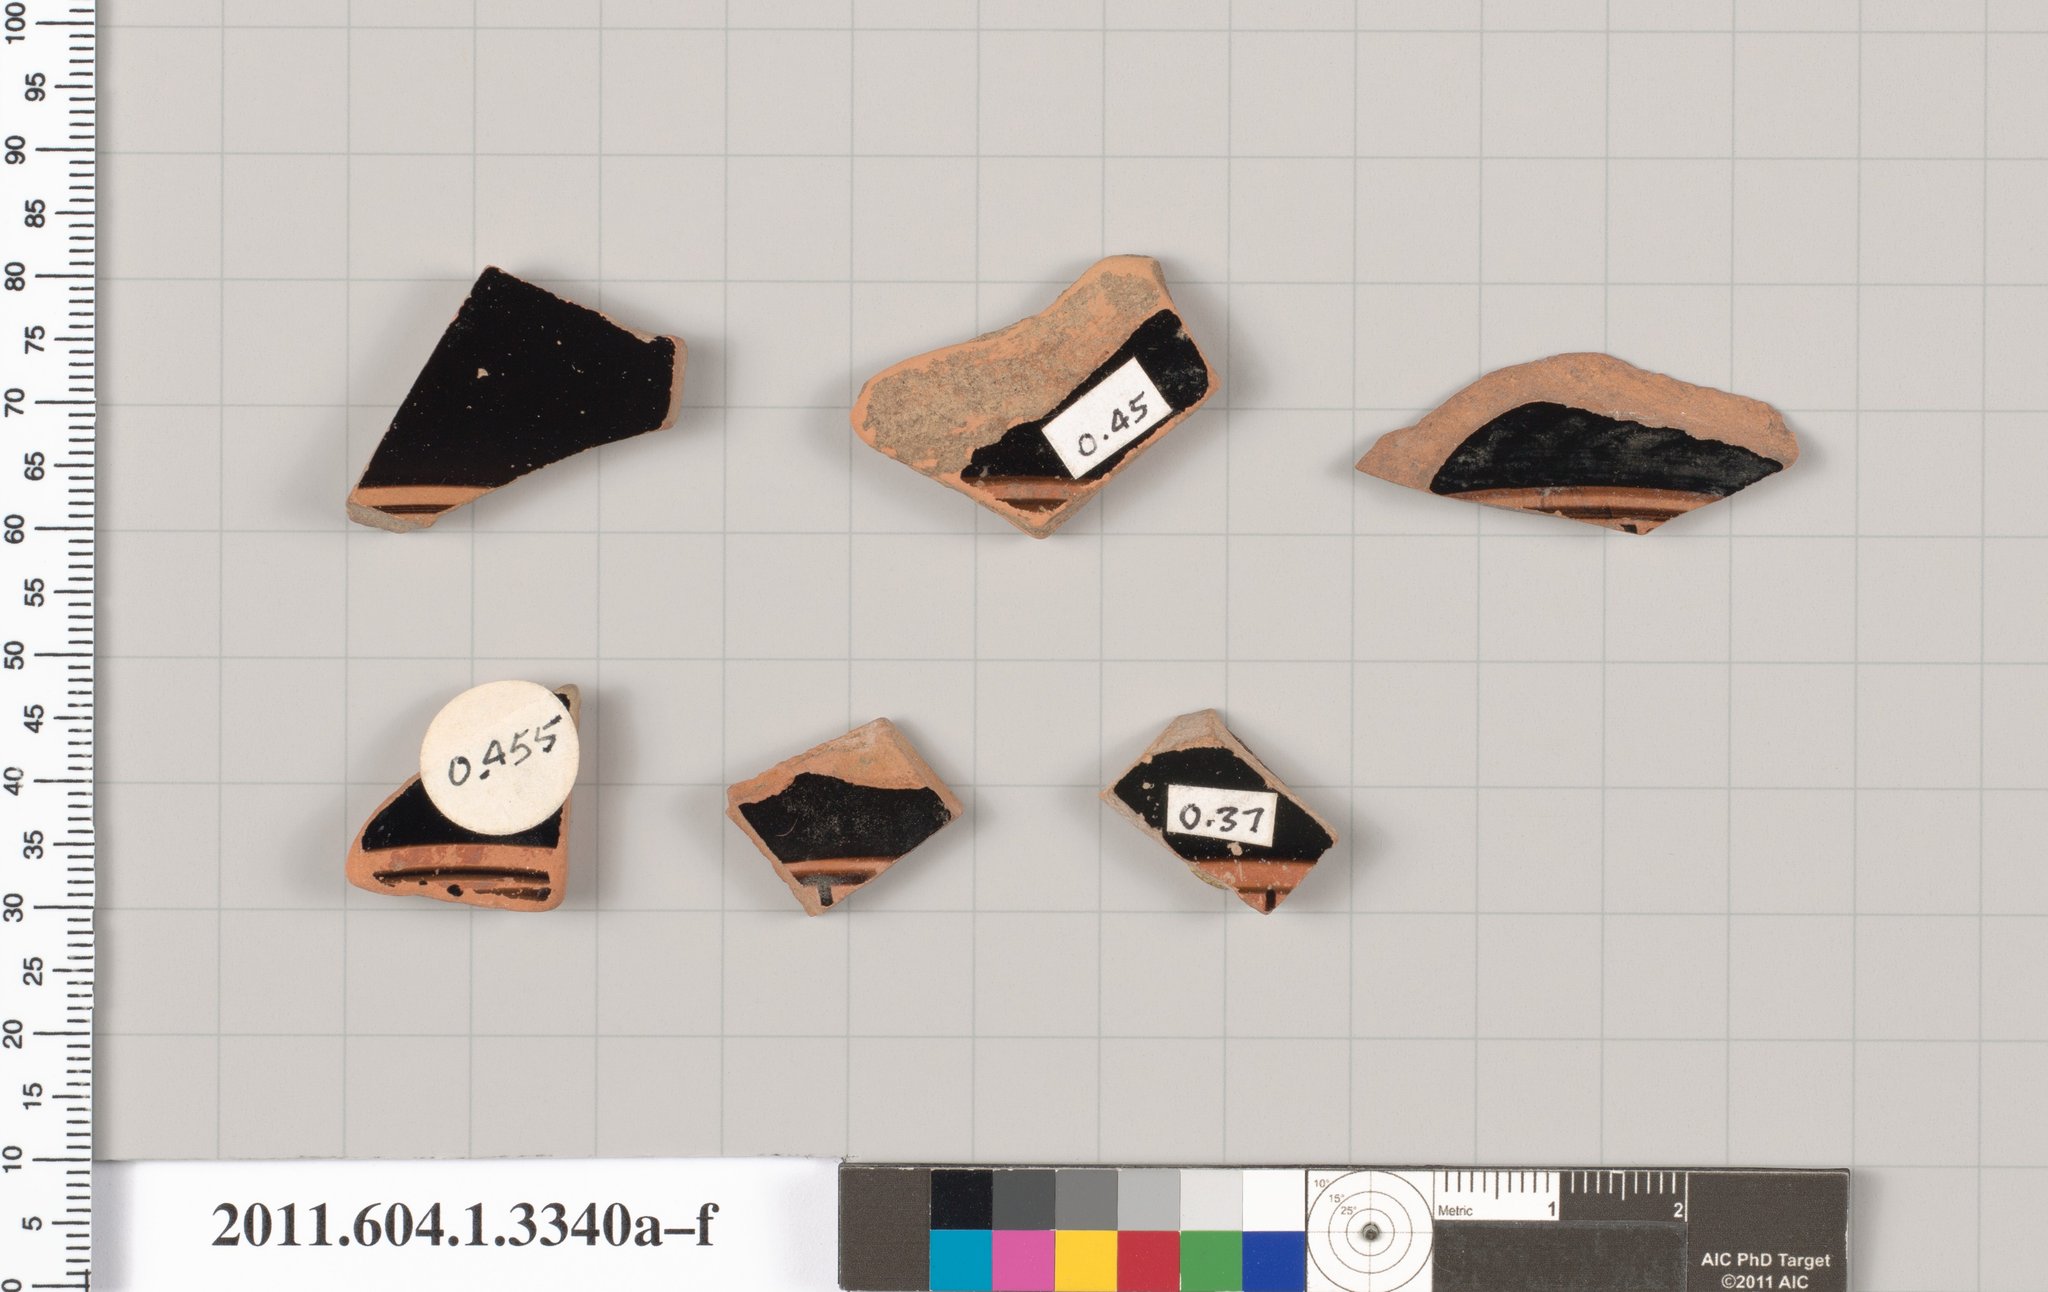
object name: kylix fragment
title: Terracotta fragments of kylikes (drinking cups)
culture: greek, attic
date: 500-470 BCE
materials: terracotta